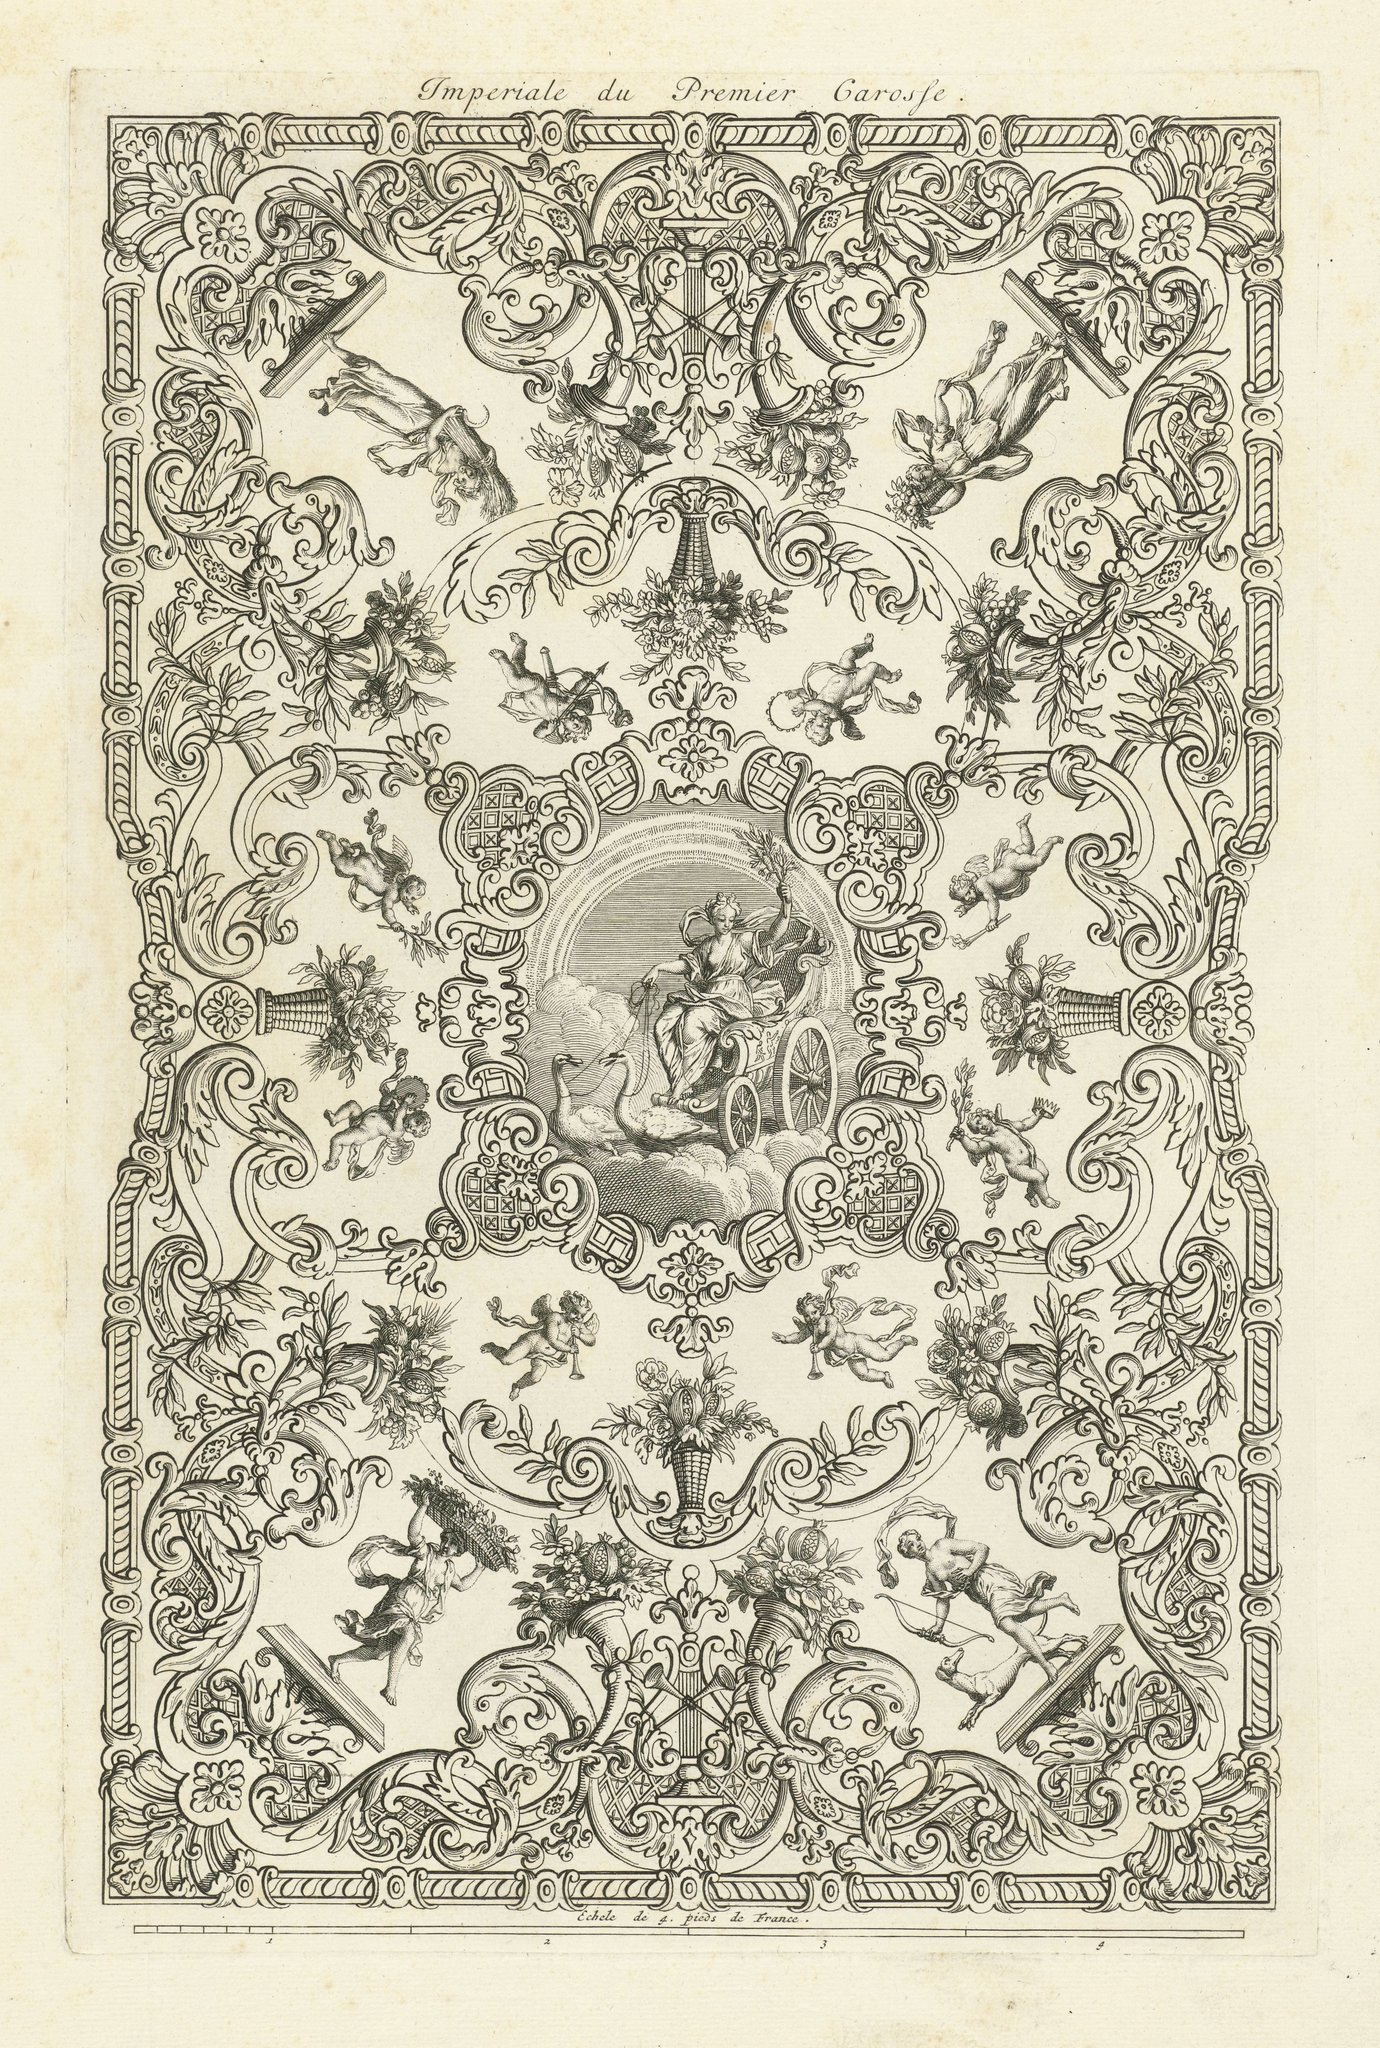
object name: print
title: Premier des Magnifiques Carosses de Monseigneur le duc d'Ossuna Ambassadeur Extraordinaire et Premier Plenipotentiaire de Sa Majesté Catholique Philippe: V. pour la Paix faits Pour l'Entreé Publique de son Excellence a Utrecht MDCCXIII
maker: bernard picart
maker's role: draughtsman, print maker, publisher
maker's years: 1673-1733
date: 1714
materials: paper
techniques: engraving, etching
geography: amsterdam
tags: ornaments ~ art, four-wheeled, animal-drawn vehicle, e.g.: cab, carriage, coach, embroidery (ornamentation), utrecht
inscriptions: collector's mark: Lugt 2228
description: Geborduurd kleed voor de bovenkant van de gouden koets met Venus in haar strijdwagen in de wolken. Onderdeel van een serie van zeven platen met de statiekoets van de Spaanse gezant de hertog van Ossuna, gebruikt bij zijn openbare intocht in Utrecht voor de vredesonderhandelingen in 1713.